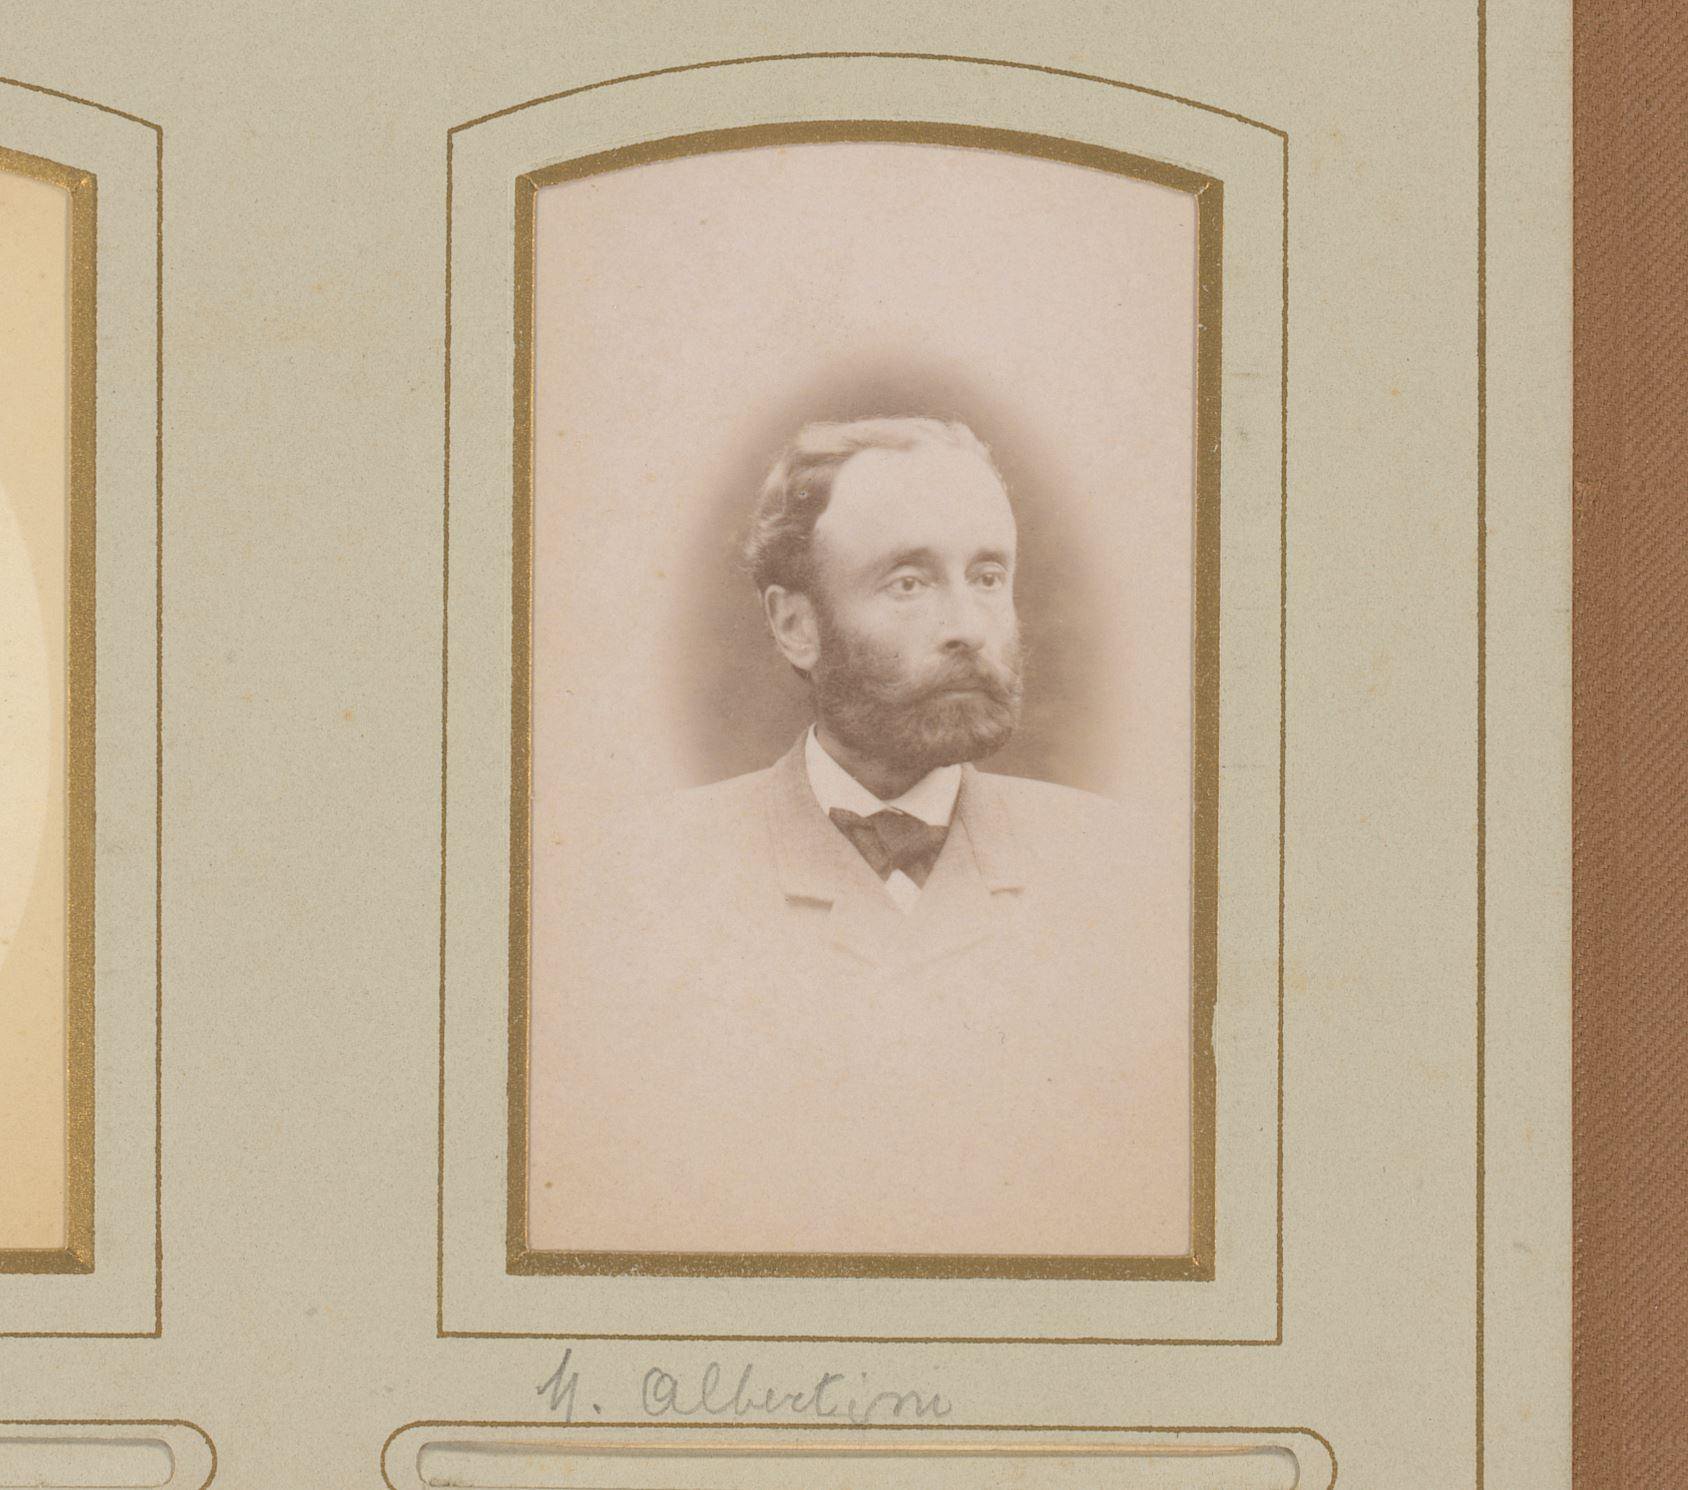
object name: album leaf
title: Portret van een man met baard, aangeduid als M. Albertine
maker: eugene guérin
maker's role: fotograaf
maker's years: 1845-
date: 1875-1885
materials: cardboard, photographic support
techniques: albumen print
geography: brussels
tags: historical persons, beard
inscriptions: inscription: ‘MÉDAILLE D'OR NAPLES 1874/ MENTION HONORABLE EXPon UNIVle PARIS 1878/ Eugene Guerin/ 142, Rue Royale, 142/ Bruxelles’, name: ‘M Albertine’